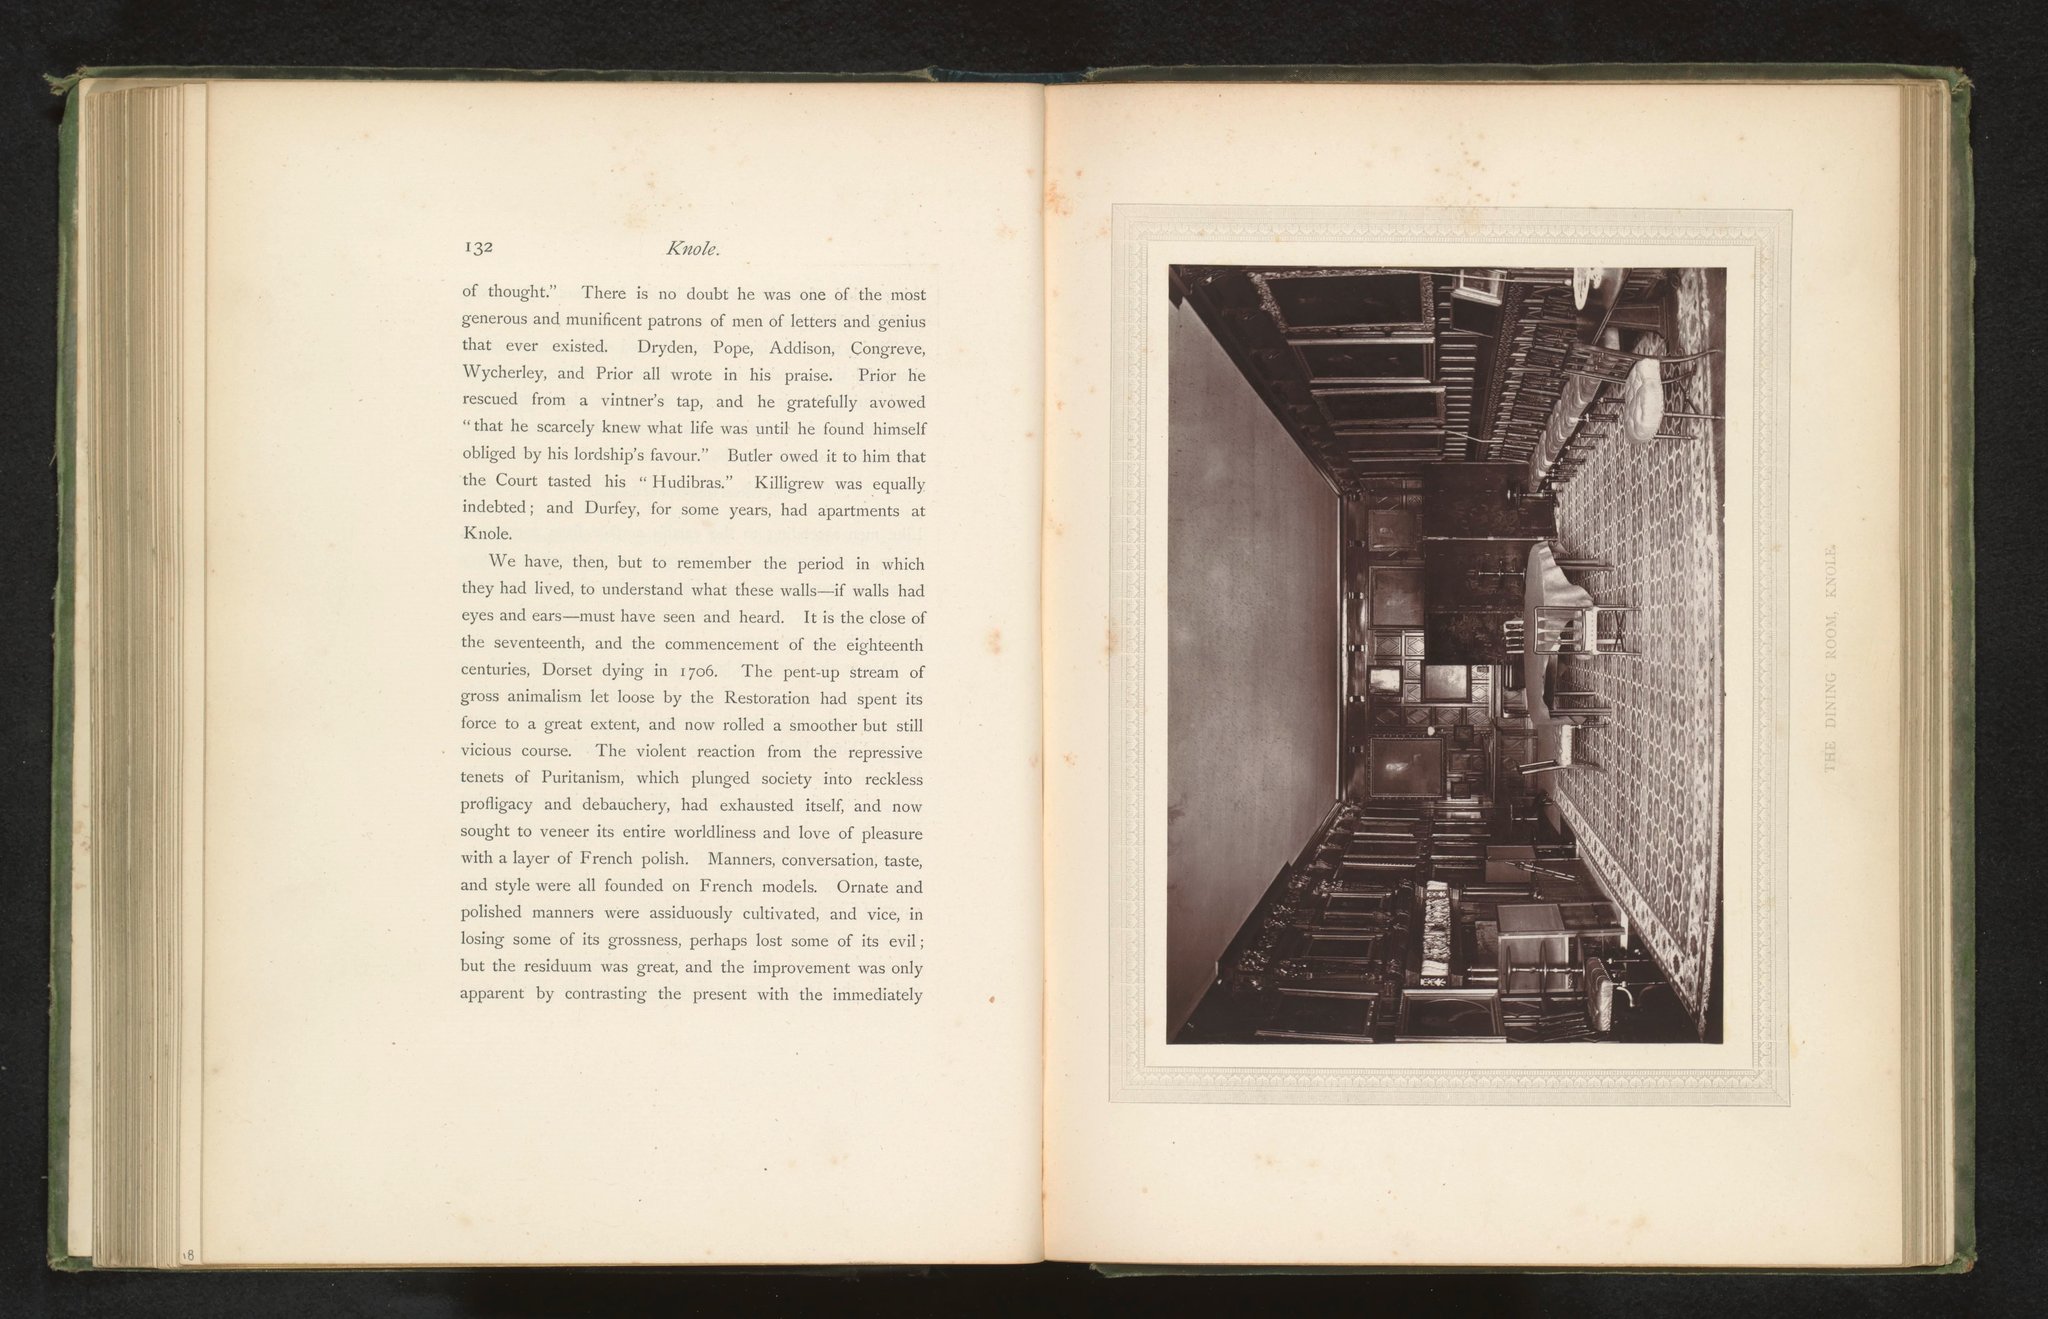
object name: photomechanical print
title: The dining room, Knole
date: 1866-1876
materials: paper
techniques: woodburytype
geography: knole house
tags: interior of the house, dining-room